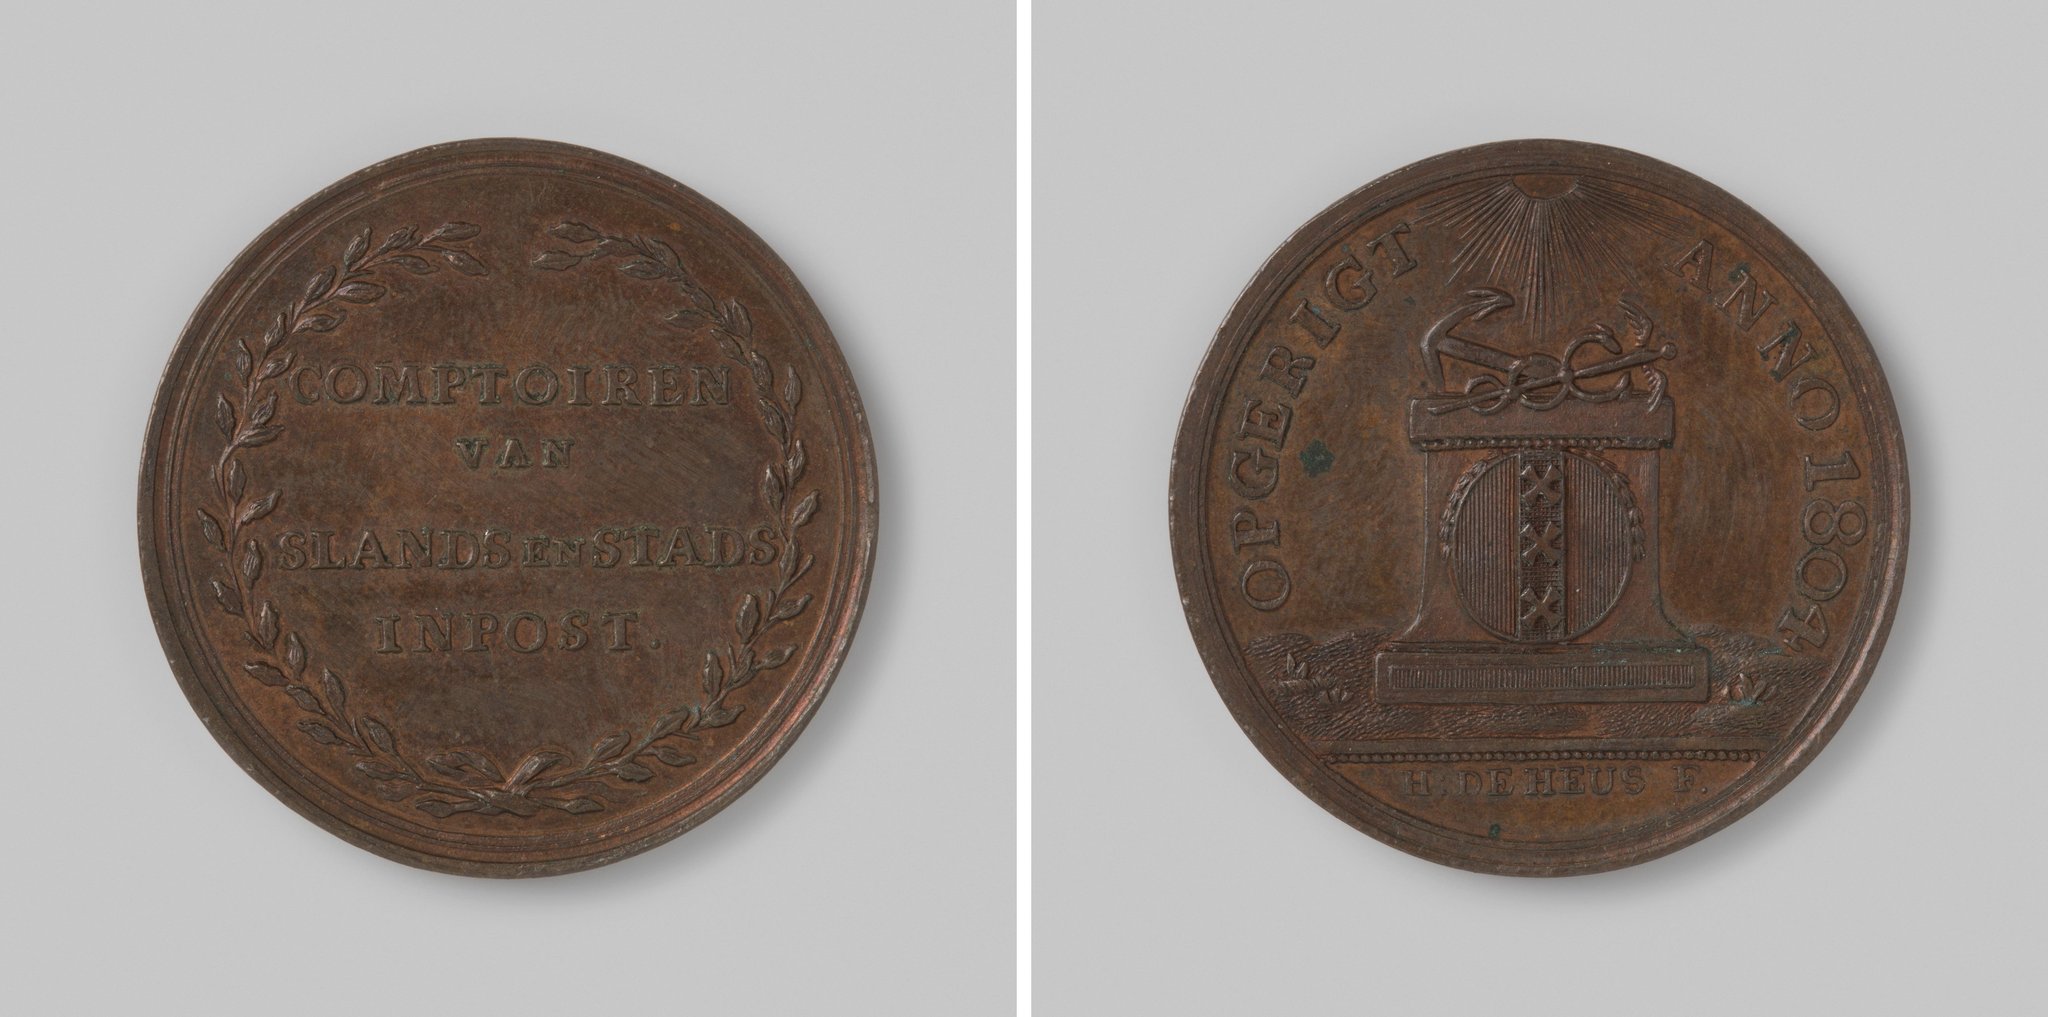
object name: history medal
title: Oprichting van de Comptoiren van 's Lands en Stads Impost te Amsterdam 1804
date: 1804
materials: copper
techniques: striking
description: Koperen penning, op de voorzijde vier regels tekst tussen samengestrikte lauwertakken, op de keerzijde een anker en mercuriusstaf op een altaar versierd met het wapen van Amsterdam, met omschrift en afsnedetekst.